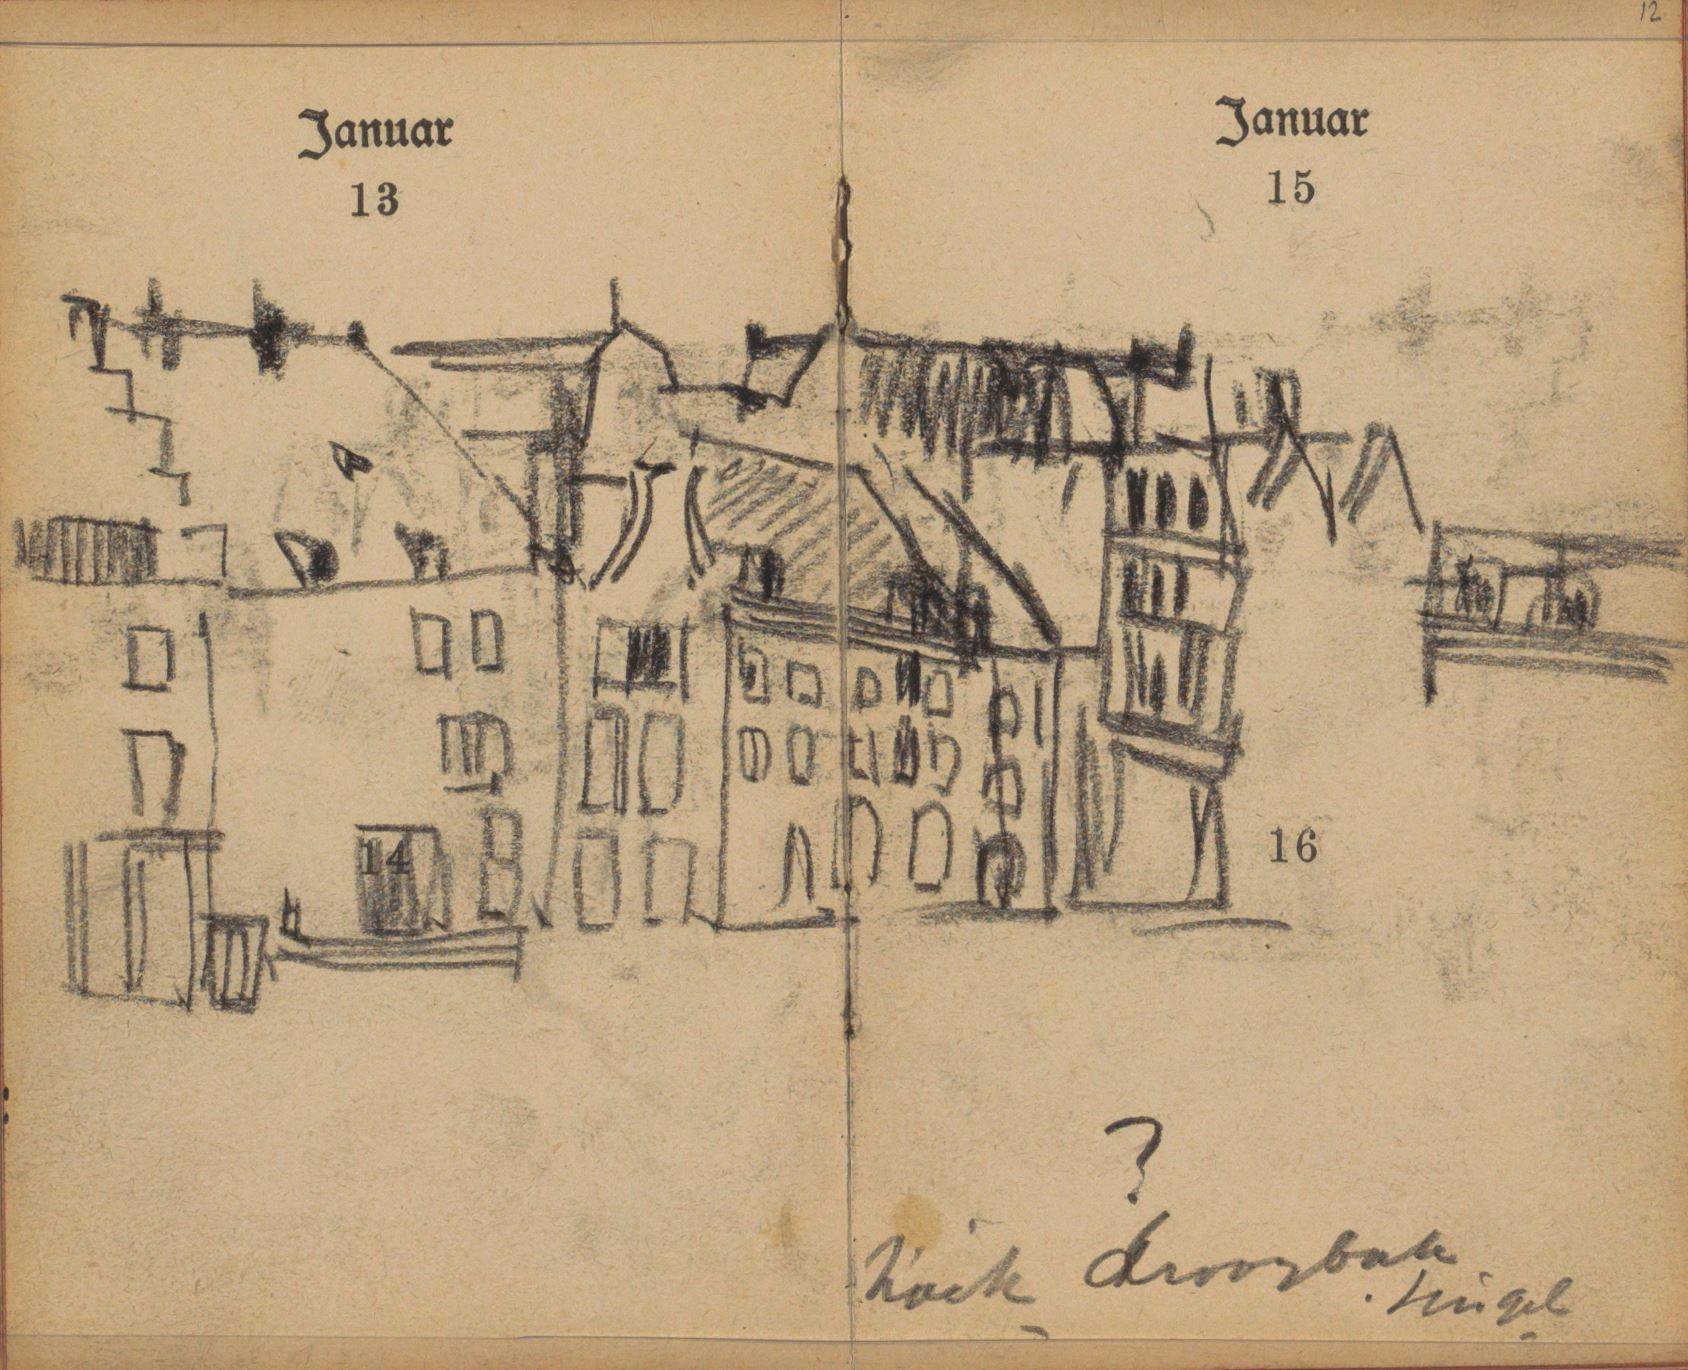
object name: sketchbook leaf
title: Gezicht op huizen op de hoek van de Droogbak en het Singel te Amsterdam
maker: george hendrik breitner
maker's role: draughtsman, painter, print maker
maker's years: 1857-1923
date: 1893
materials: chalk, paper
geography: amsterdam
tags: civic architecture; edifices; dwellings, street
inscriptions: annotation: ‘hoek droogbak/ Singel’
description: Pagina 11 en pagina 12 uit een als schetsboek gebruikte agenda met 80 bladen.